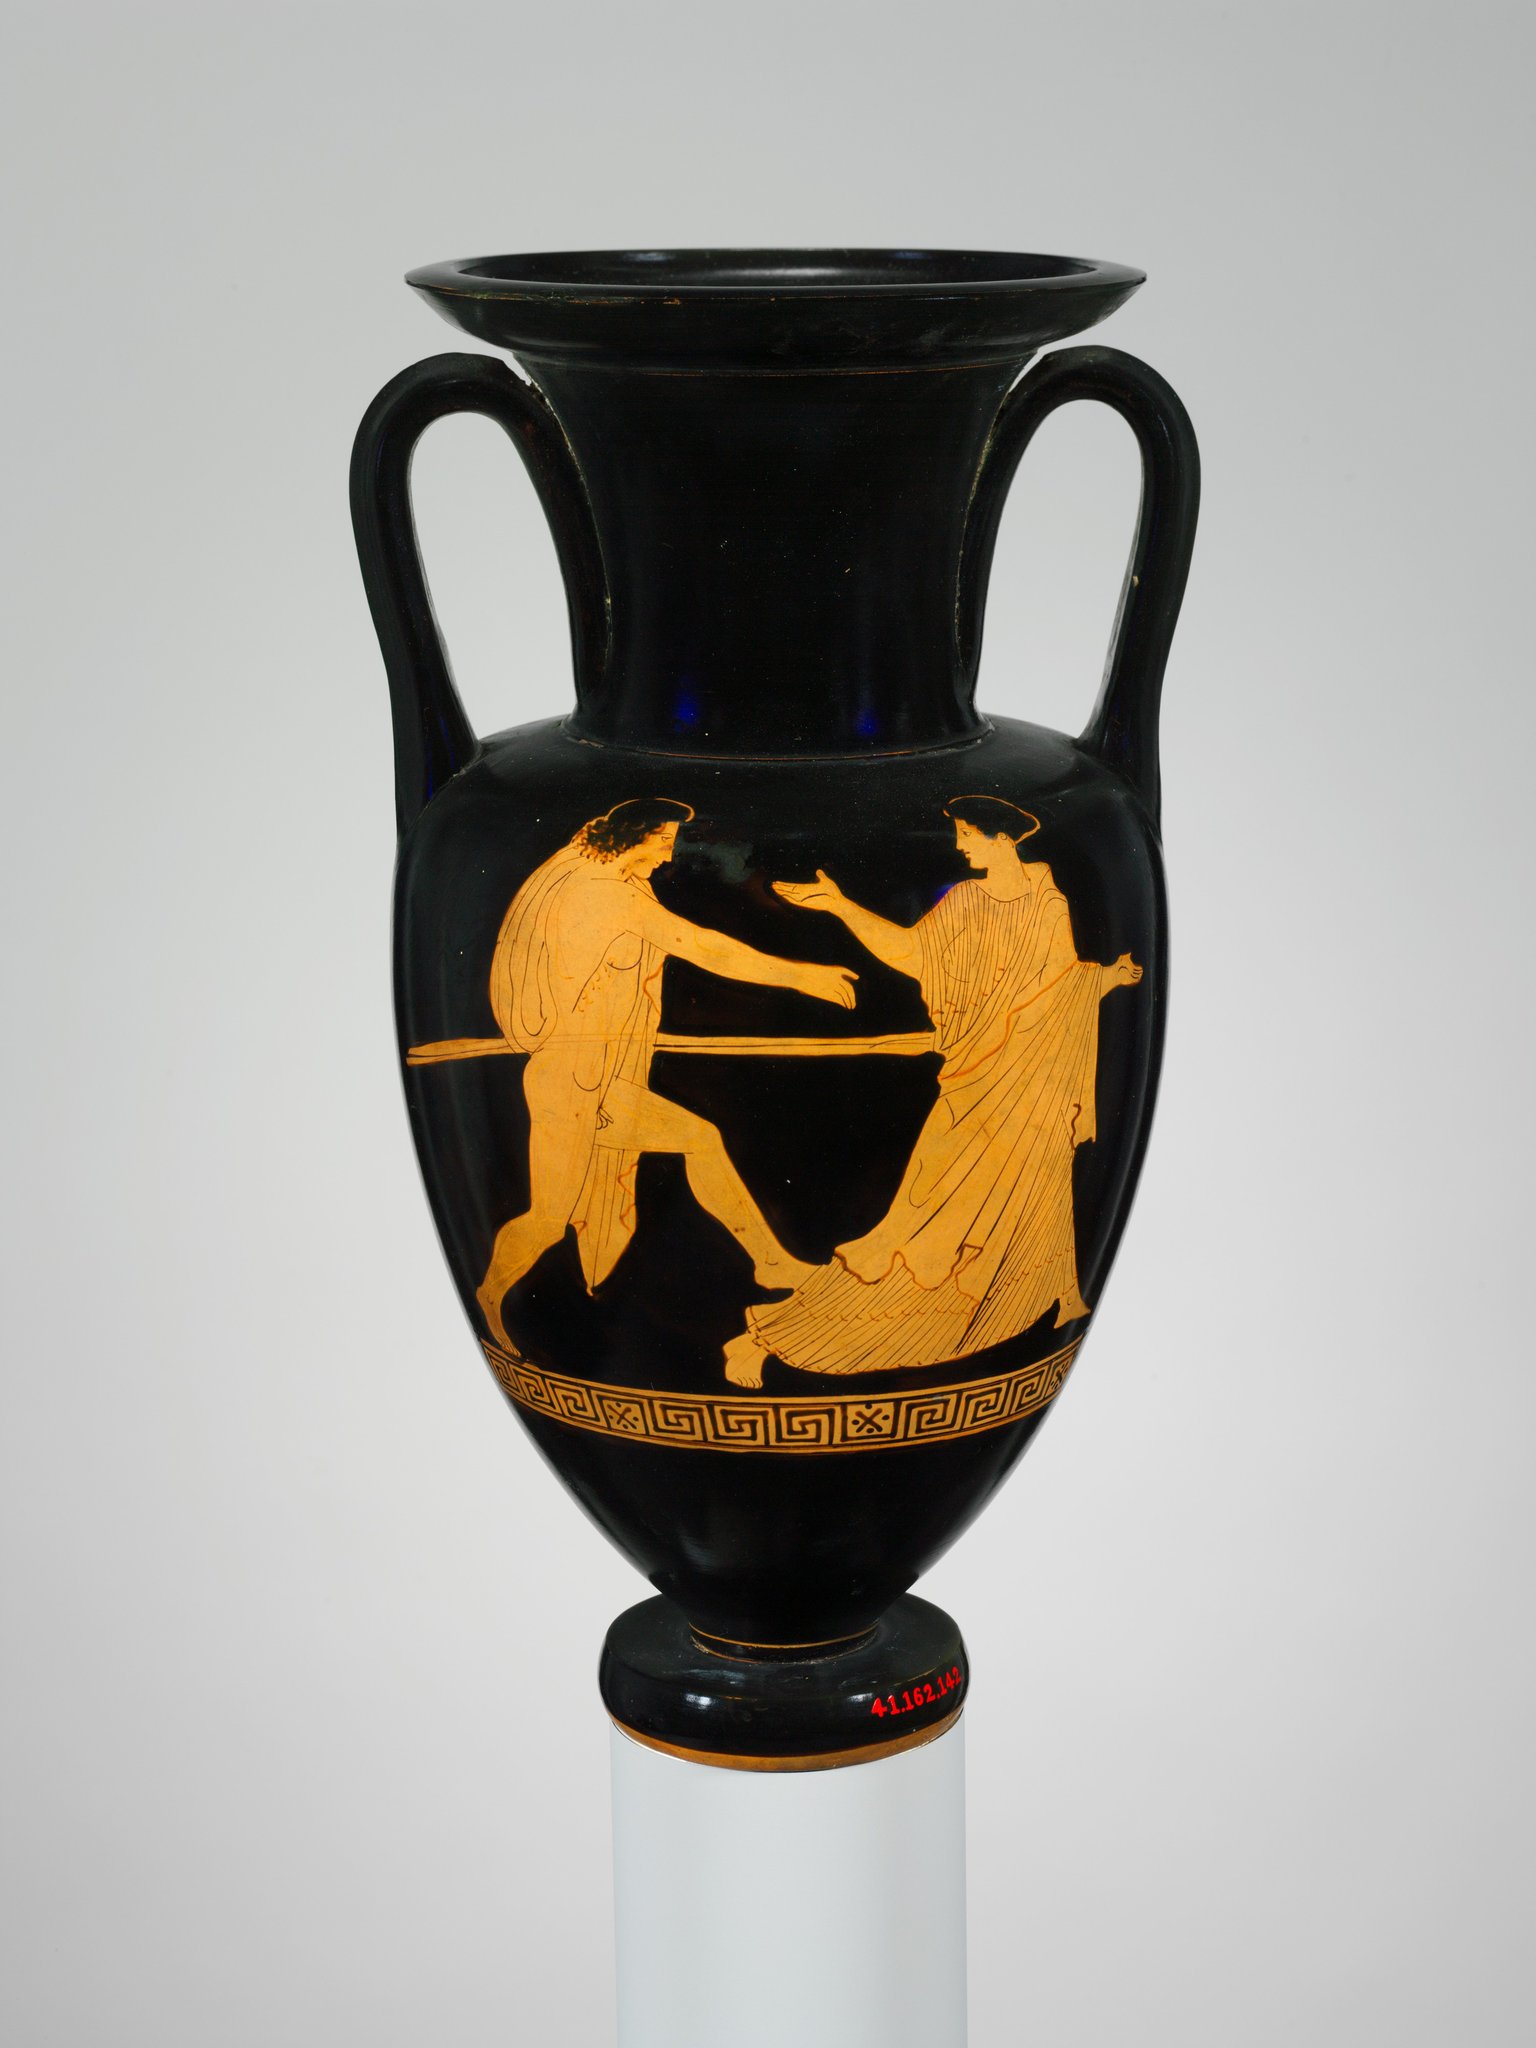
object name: nolan neck amphora with ridged handle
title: Terracotta Nolan neck-amphora (jar)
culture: greek, attic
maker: phiale painter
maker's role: artist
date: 440-430 BCE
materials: terracotta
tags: men,women